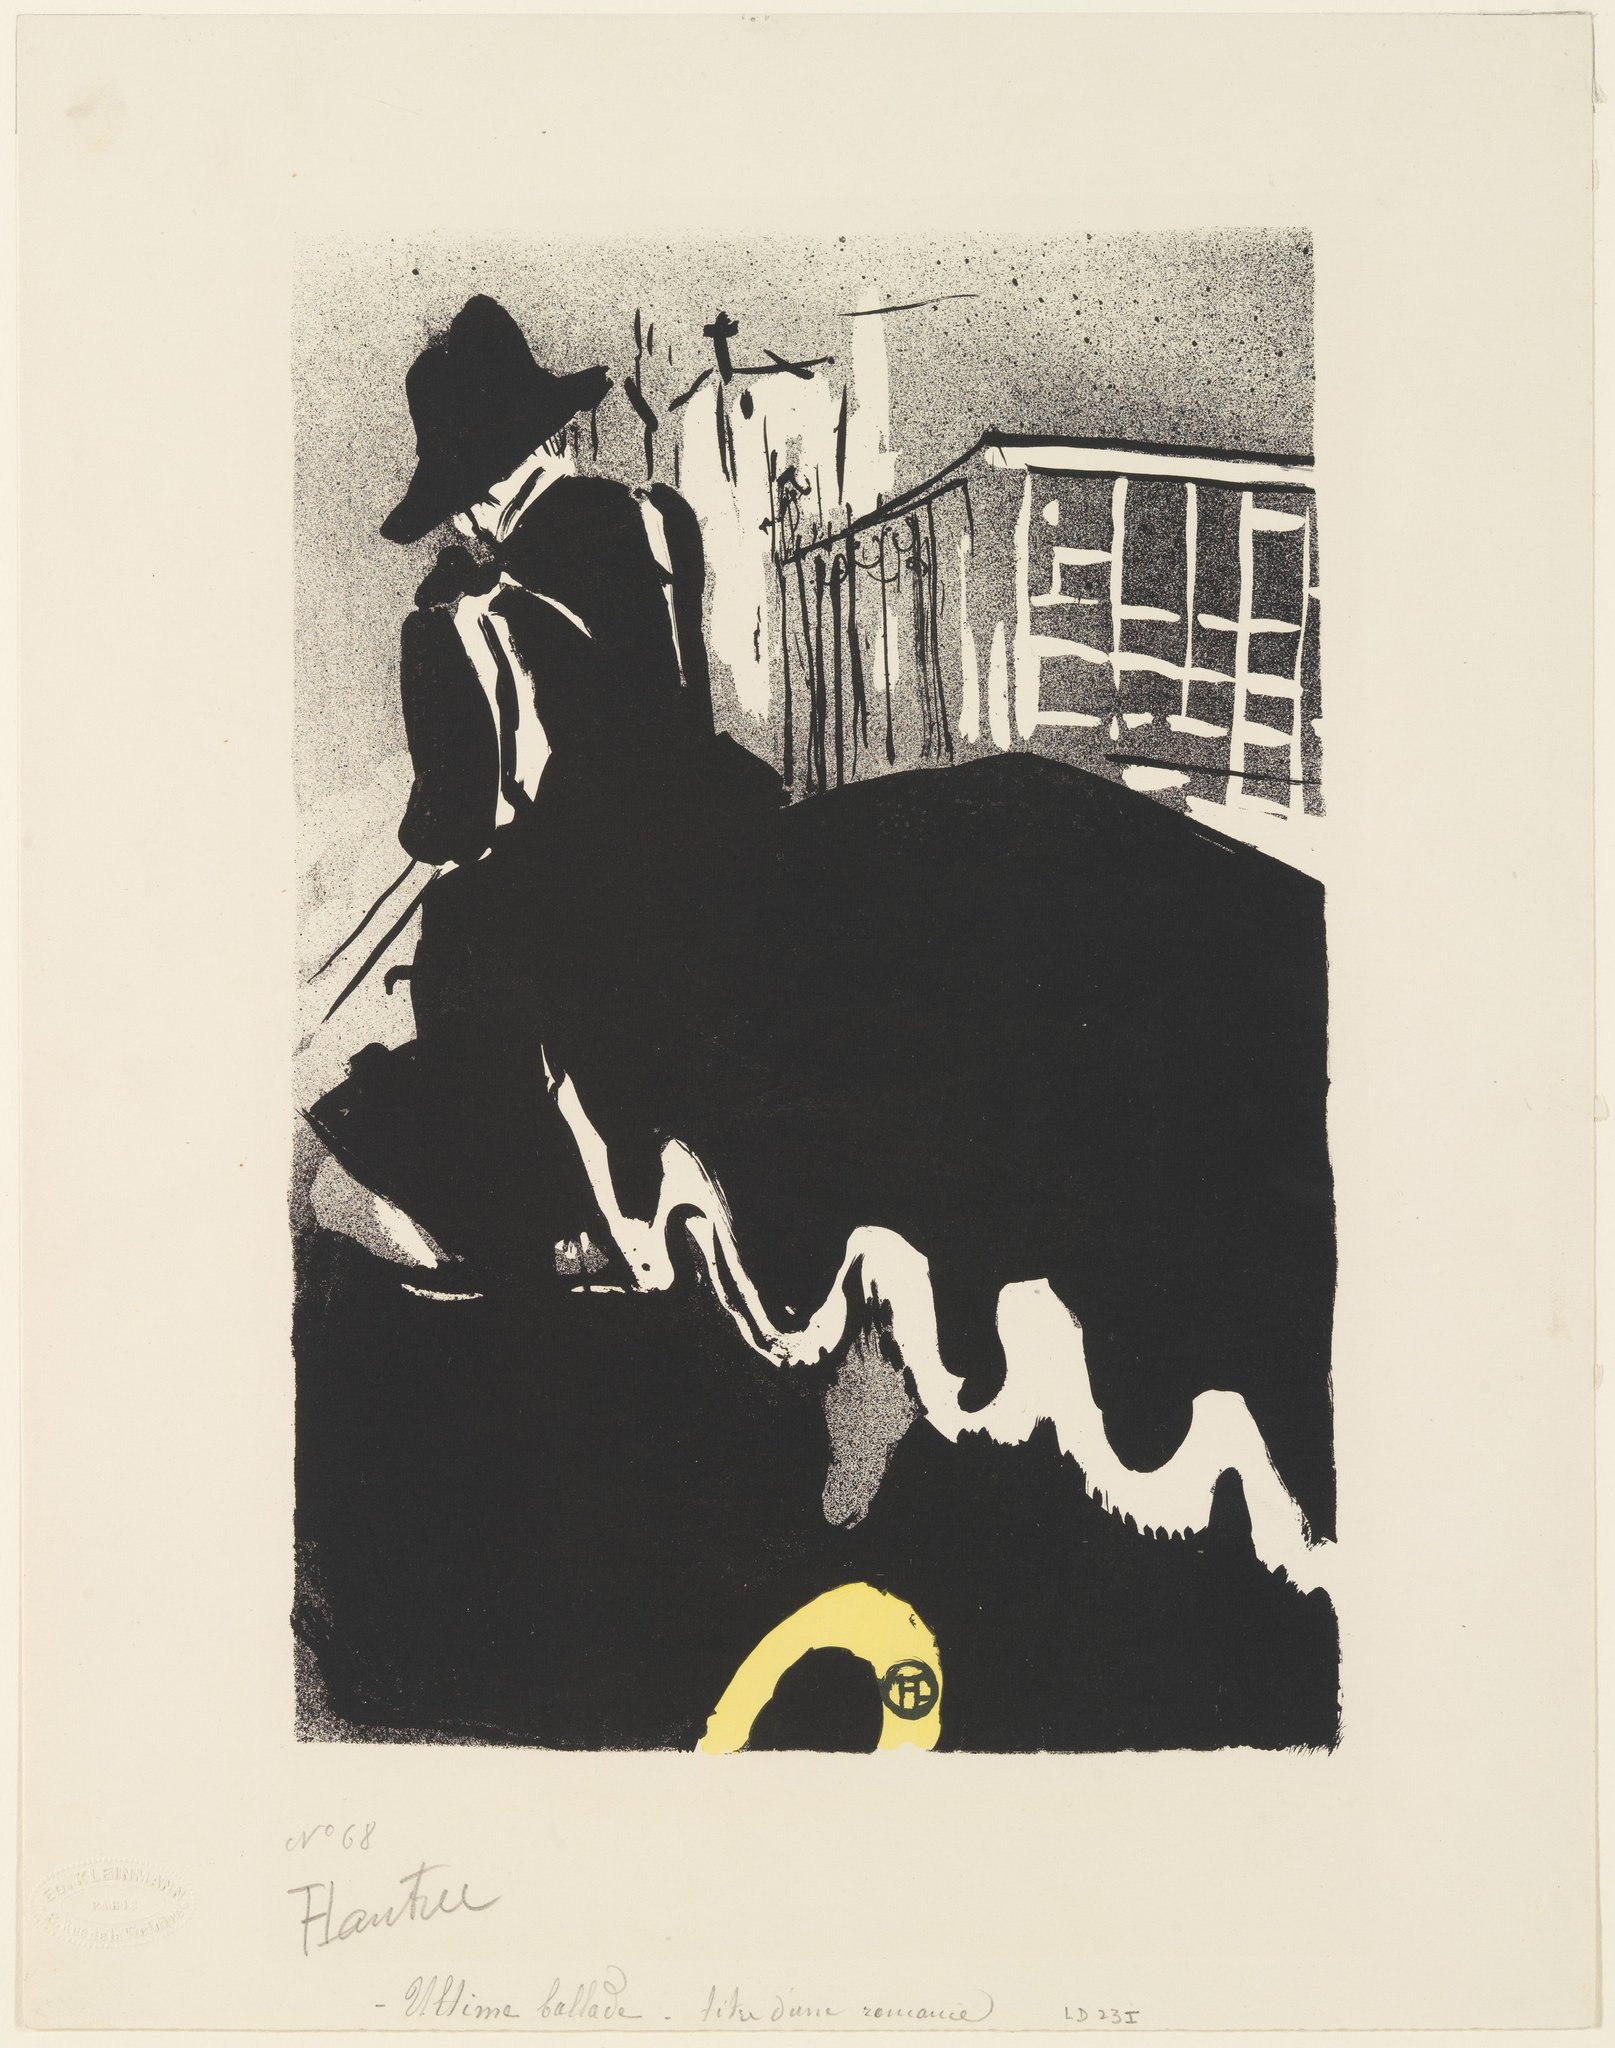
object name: print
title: The Final Outing, "from The Old Tales"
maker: henri de toulouse-lautrec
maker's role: artist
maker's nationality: french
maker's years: 1864-1901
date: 1893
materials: paper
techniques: brush, coloring, lithograph, printing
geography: france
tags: human figures